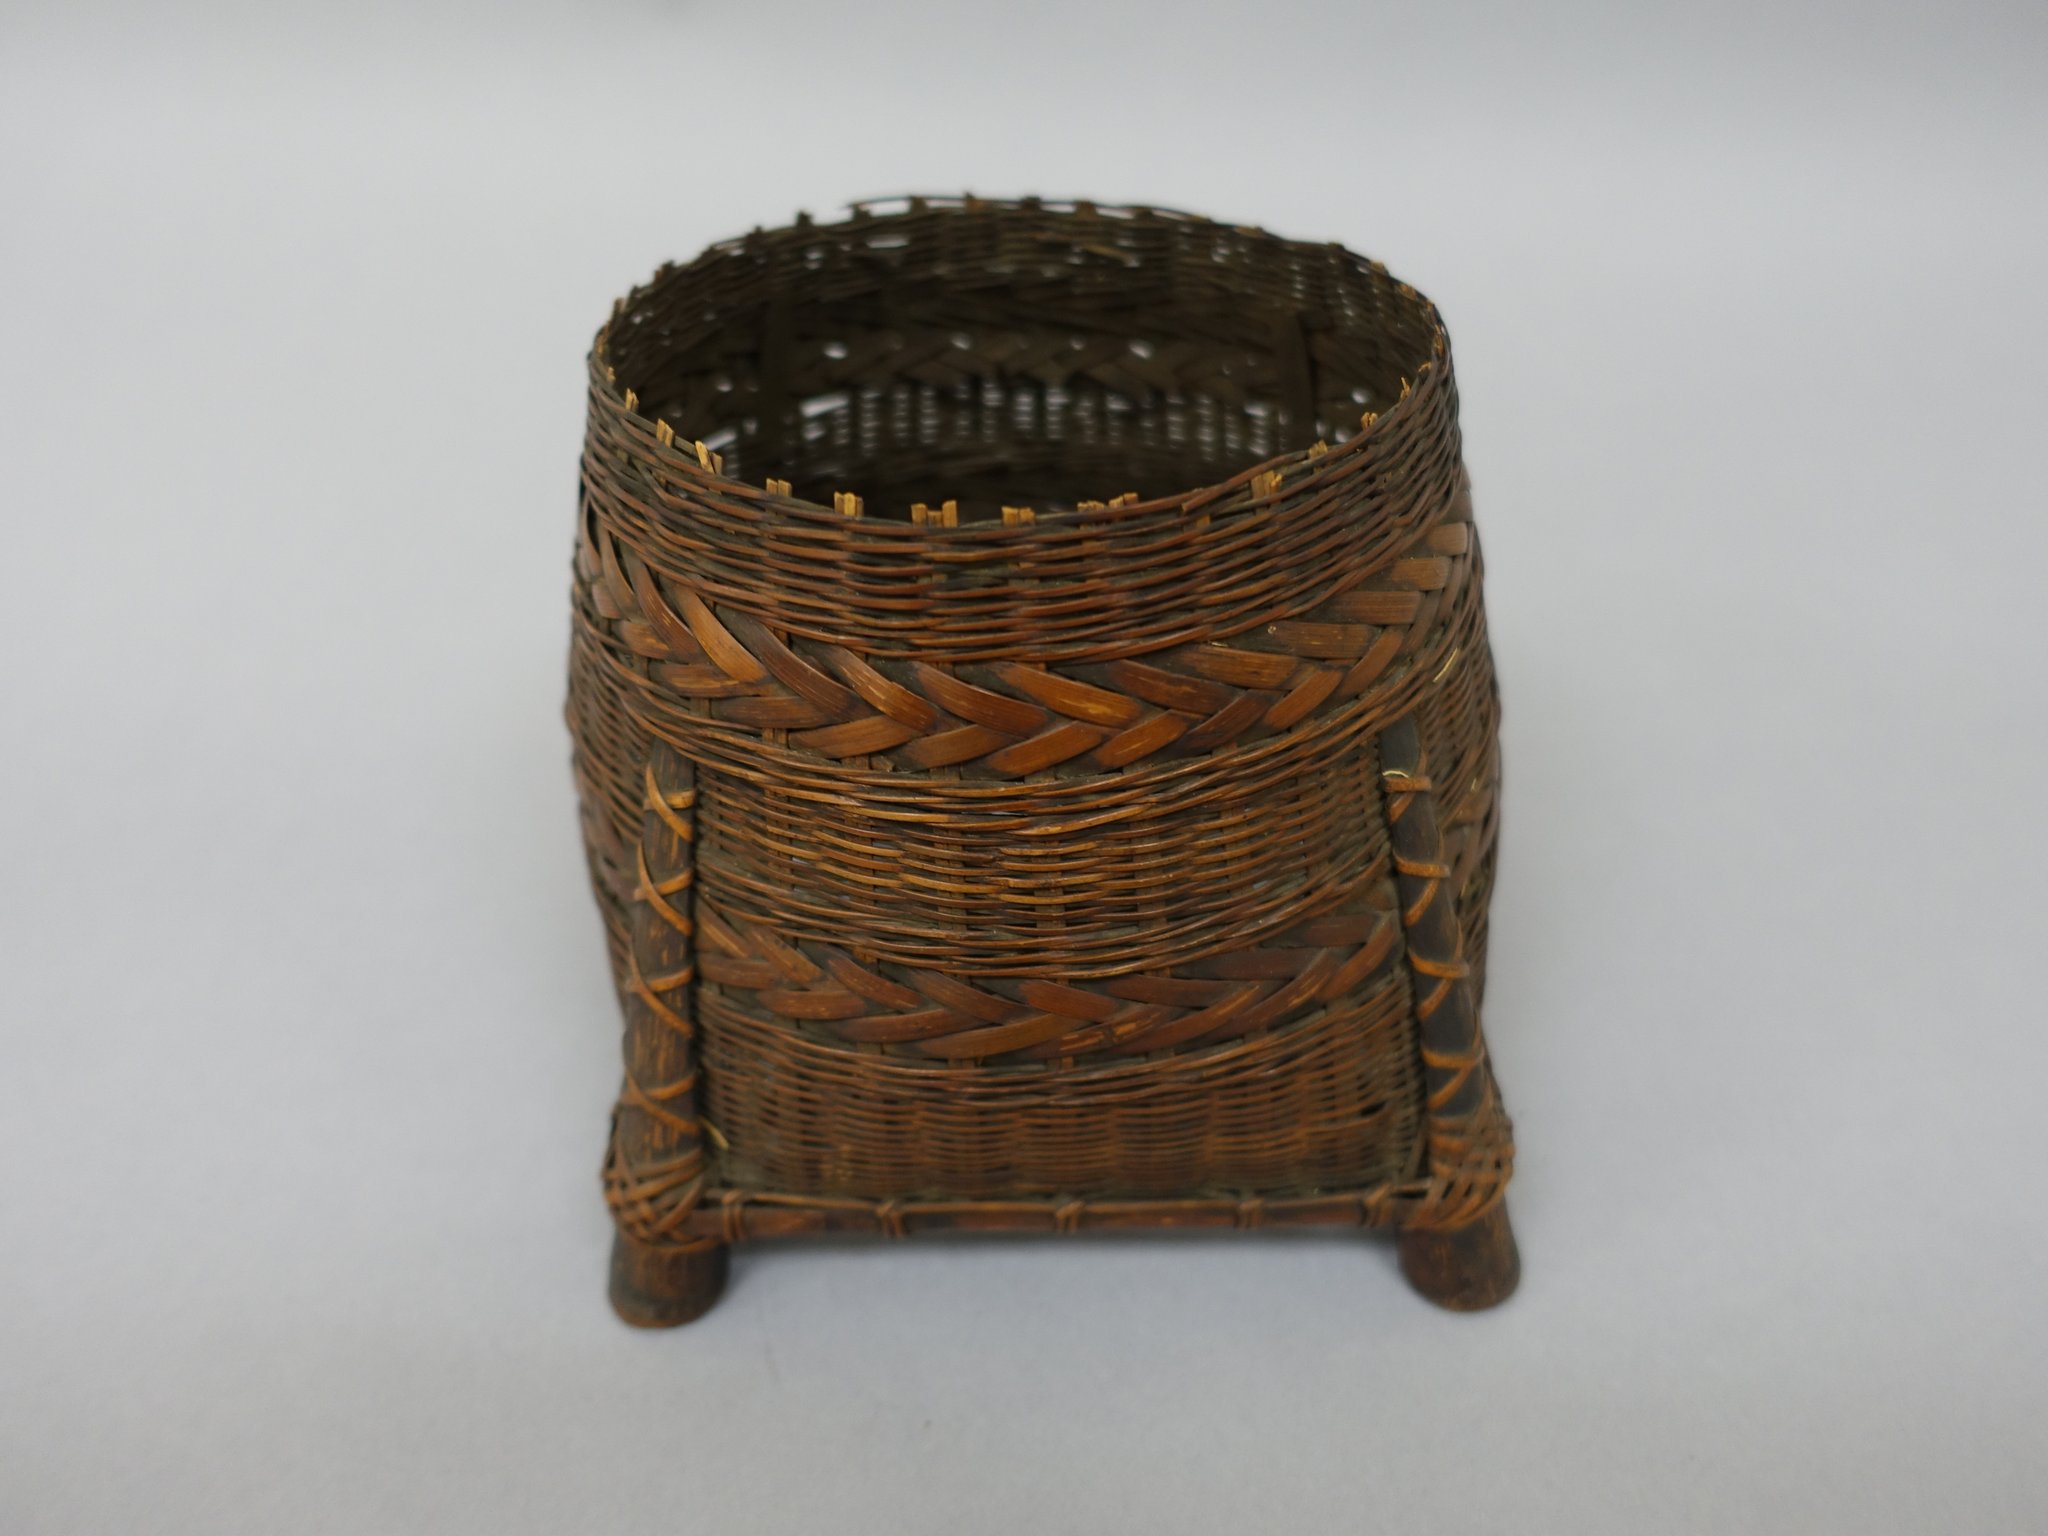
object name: basket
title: Basket (Lower Part)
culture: japanese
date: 1801-1900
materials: rattan